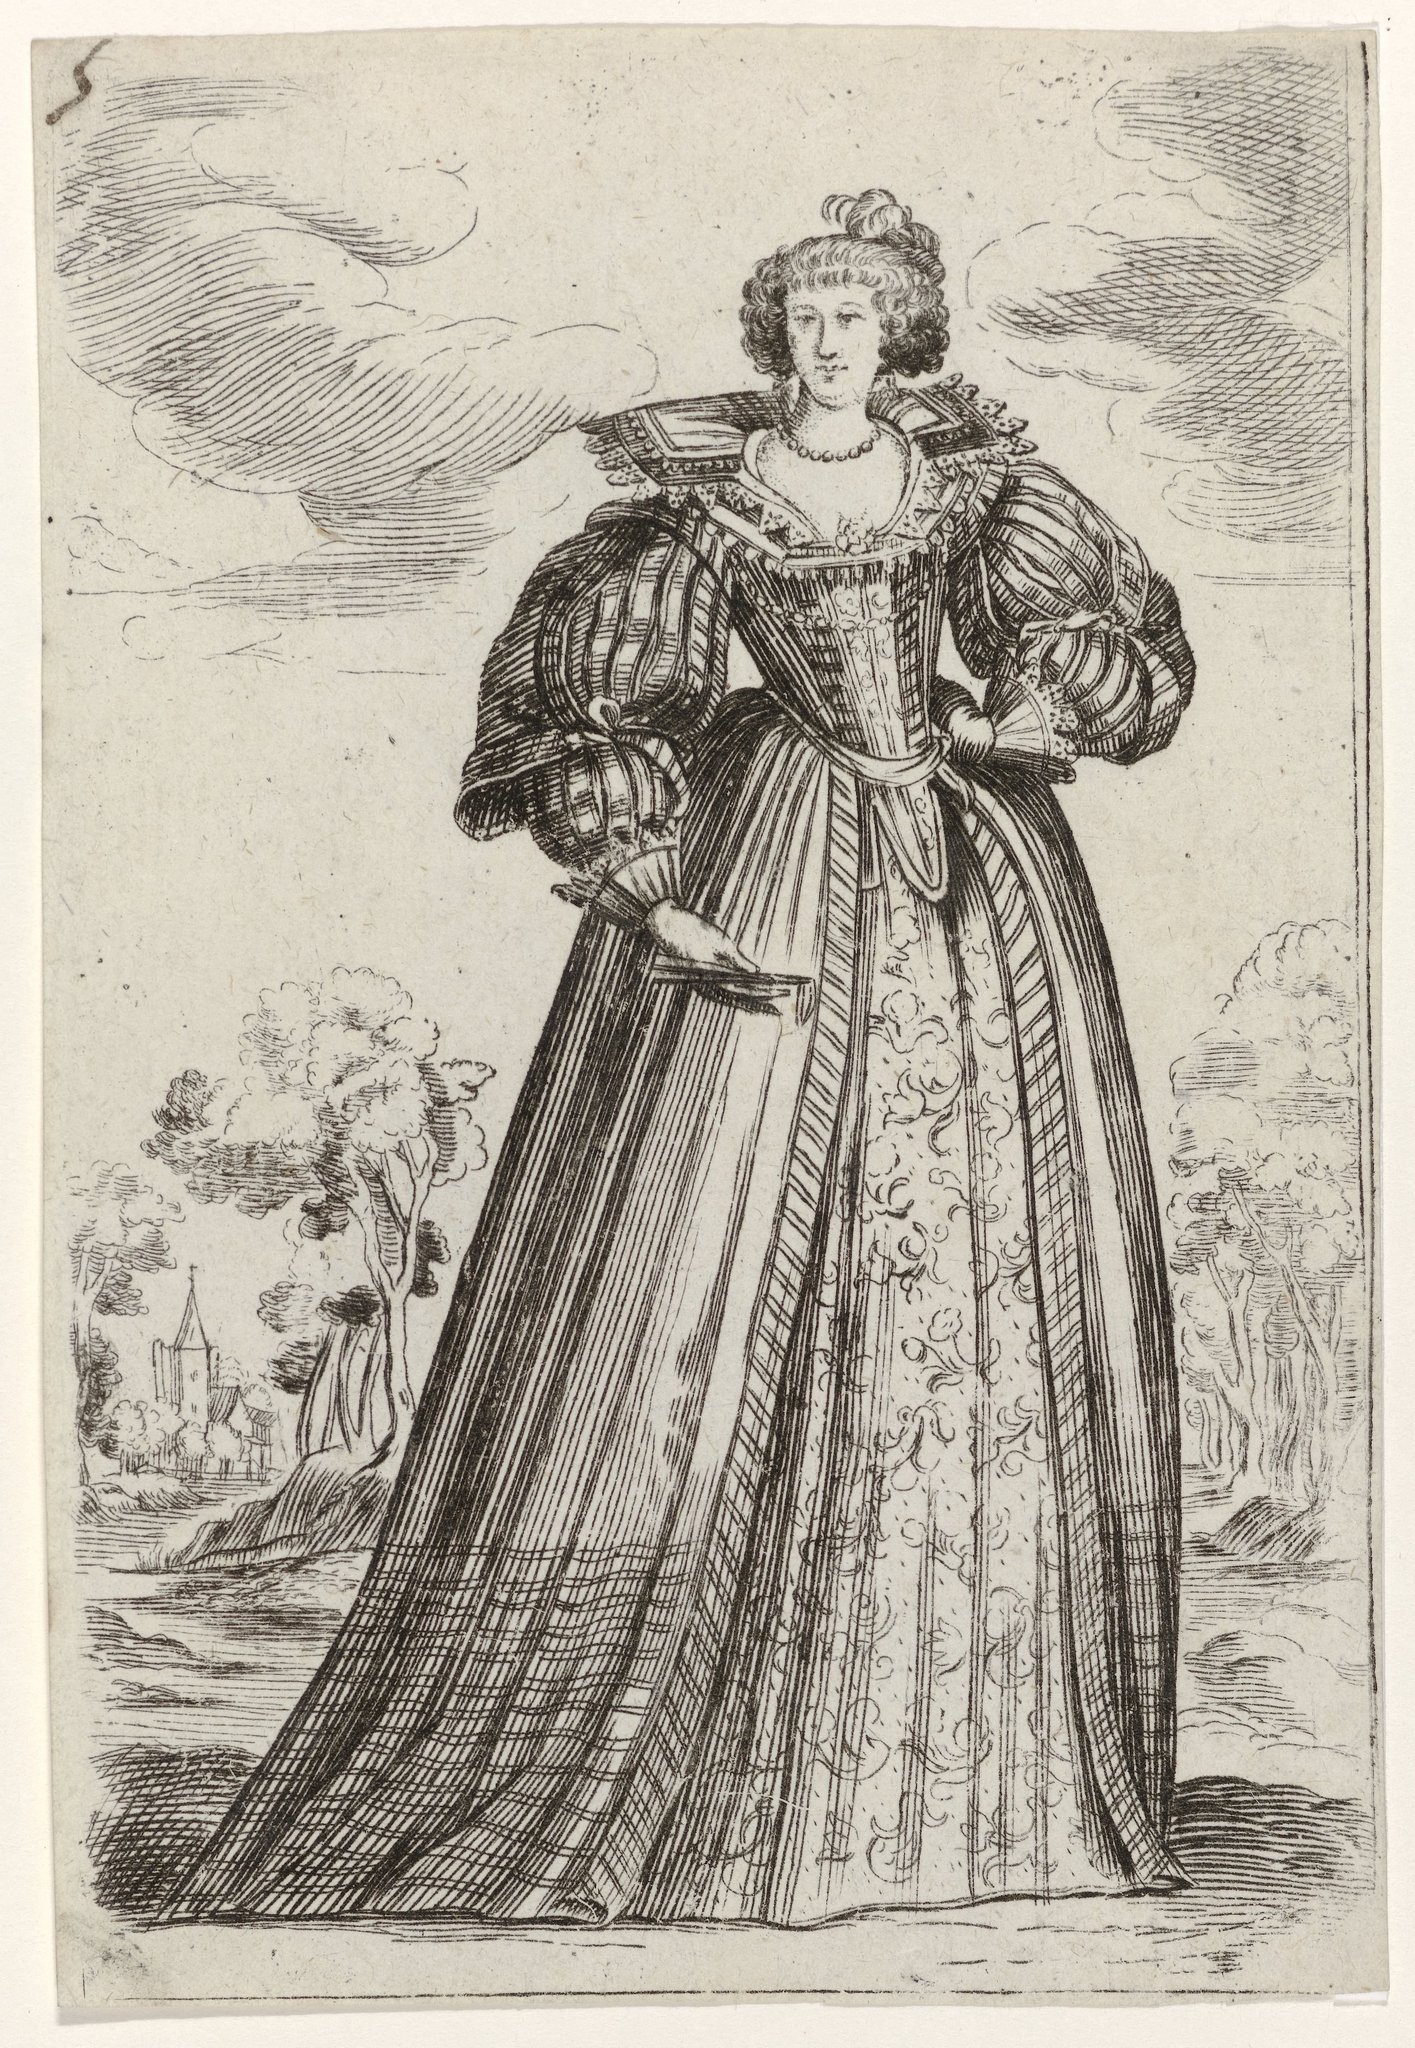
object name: print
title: Dame met gesloten waaier in de hand, van voren gezien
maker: Anonymous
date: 1629-1699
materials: paper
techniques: etching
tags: dress, gown (vlieger) (+ women's clothes), styles of hairdress - aa - ~ women, neck-gear: collar (+ women's clothes), clothes, costume (+ women's clothes), skirt (+ women's clothes), sleeves (+ women's clothes), clothing for the upper part of the body (with name) (+ women's clothes)